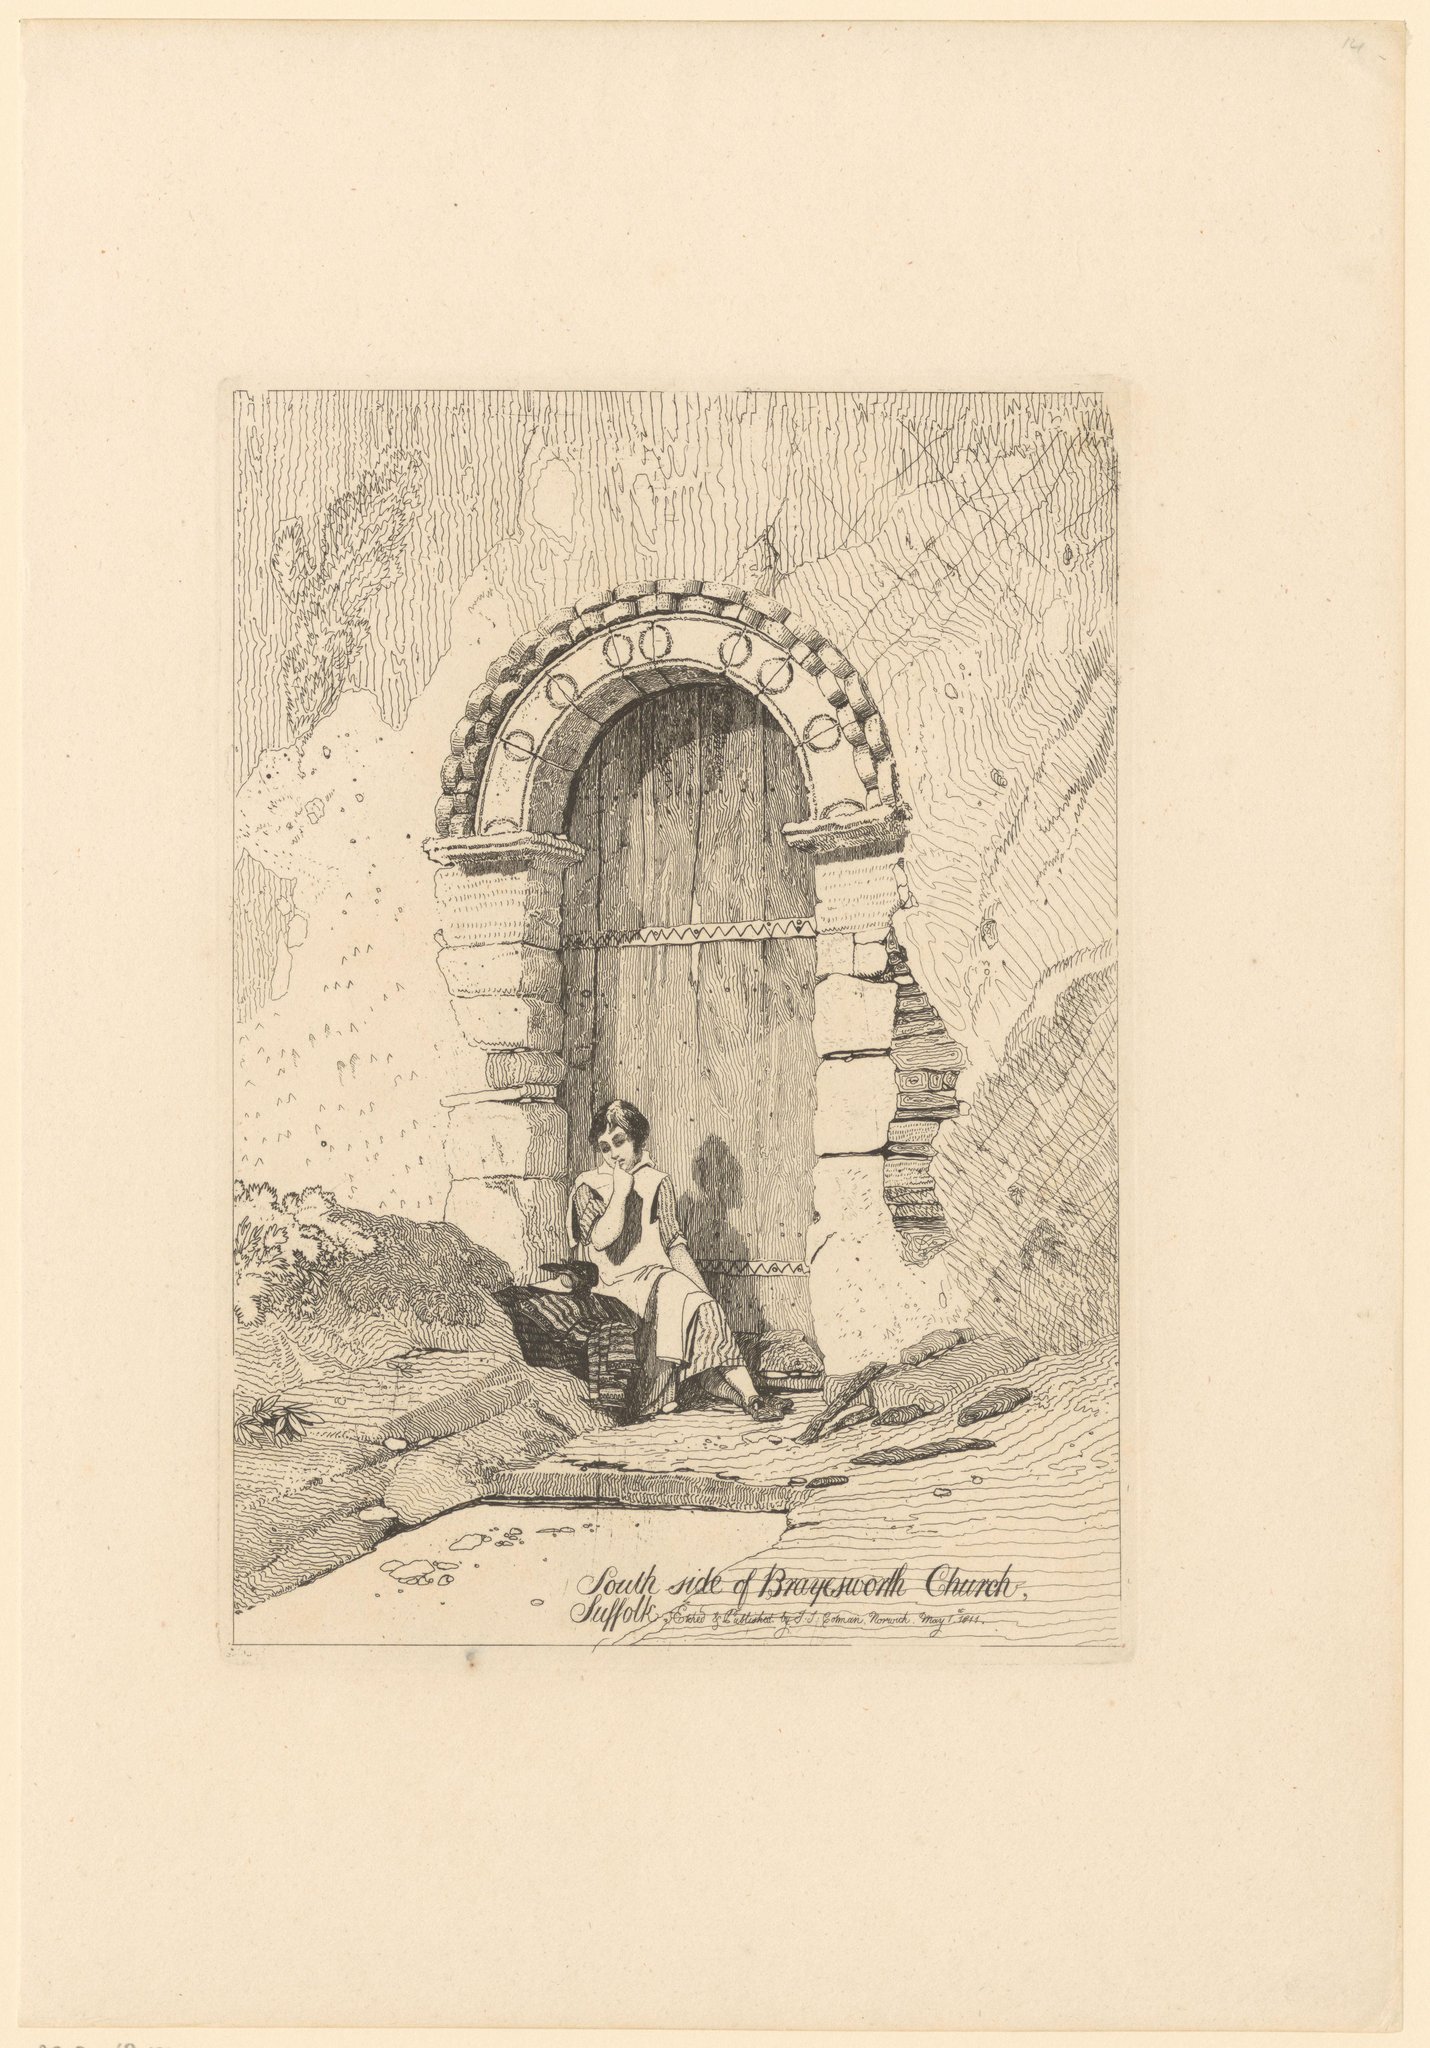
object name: print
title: South side of Brayesworth Church, Suffolk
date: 1805-1811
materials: paper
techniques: etching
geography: york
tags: child, church (exterior), gate, entrance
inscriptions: collector's mark: Lugt 2760, collector's mark: Lugt 2228